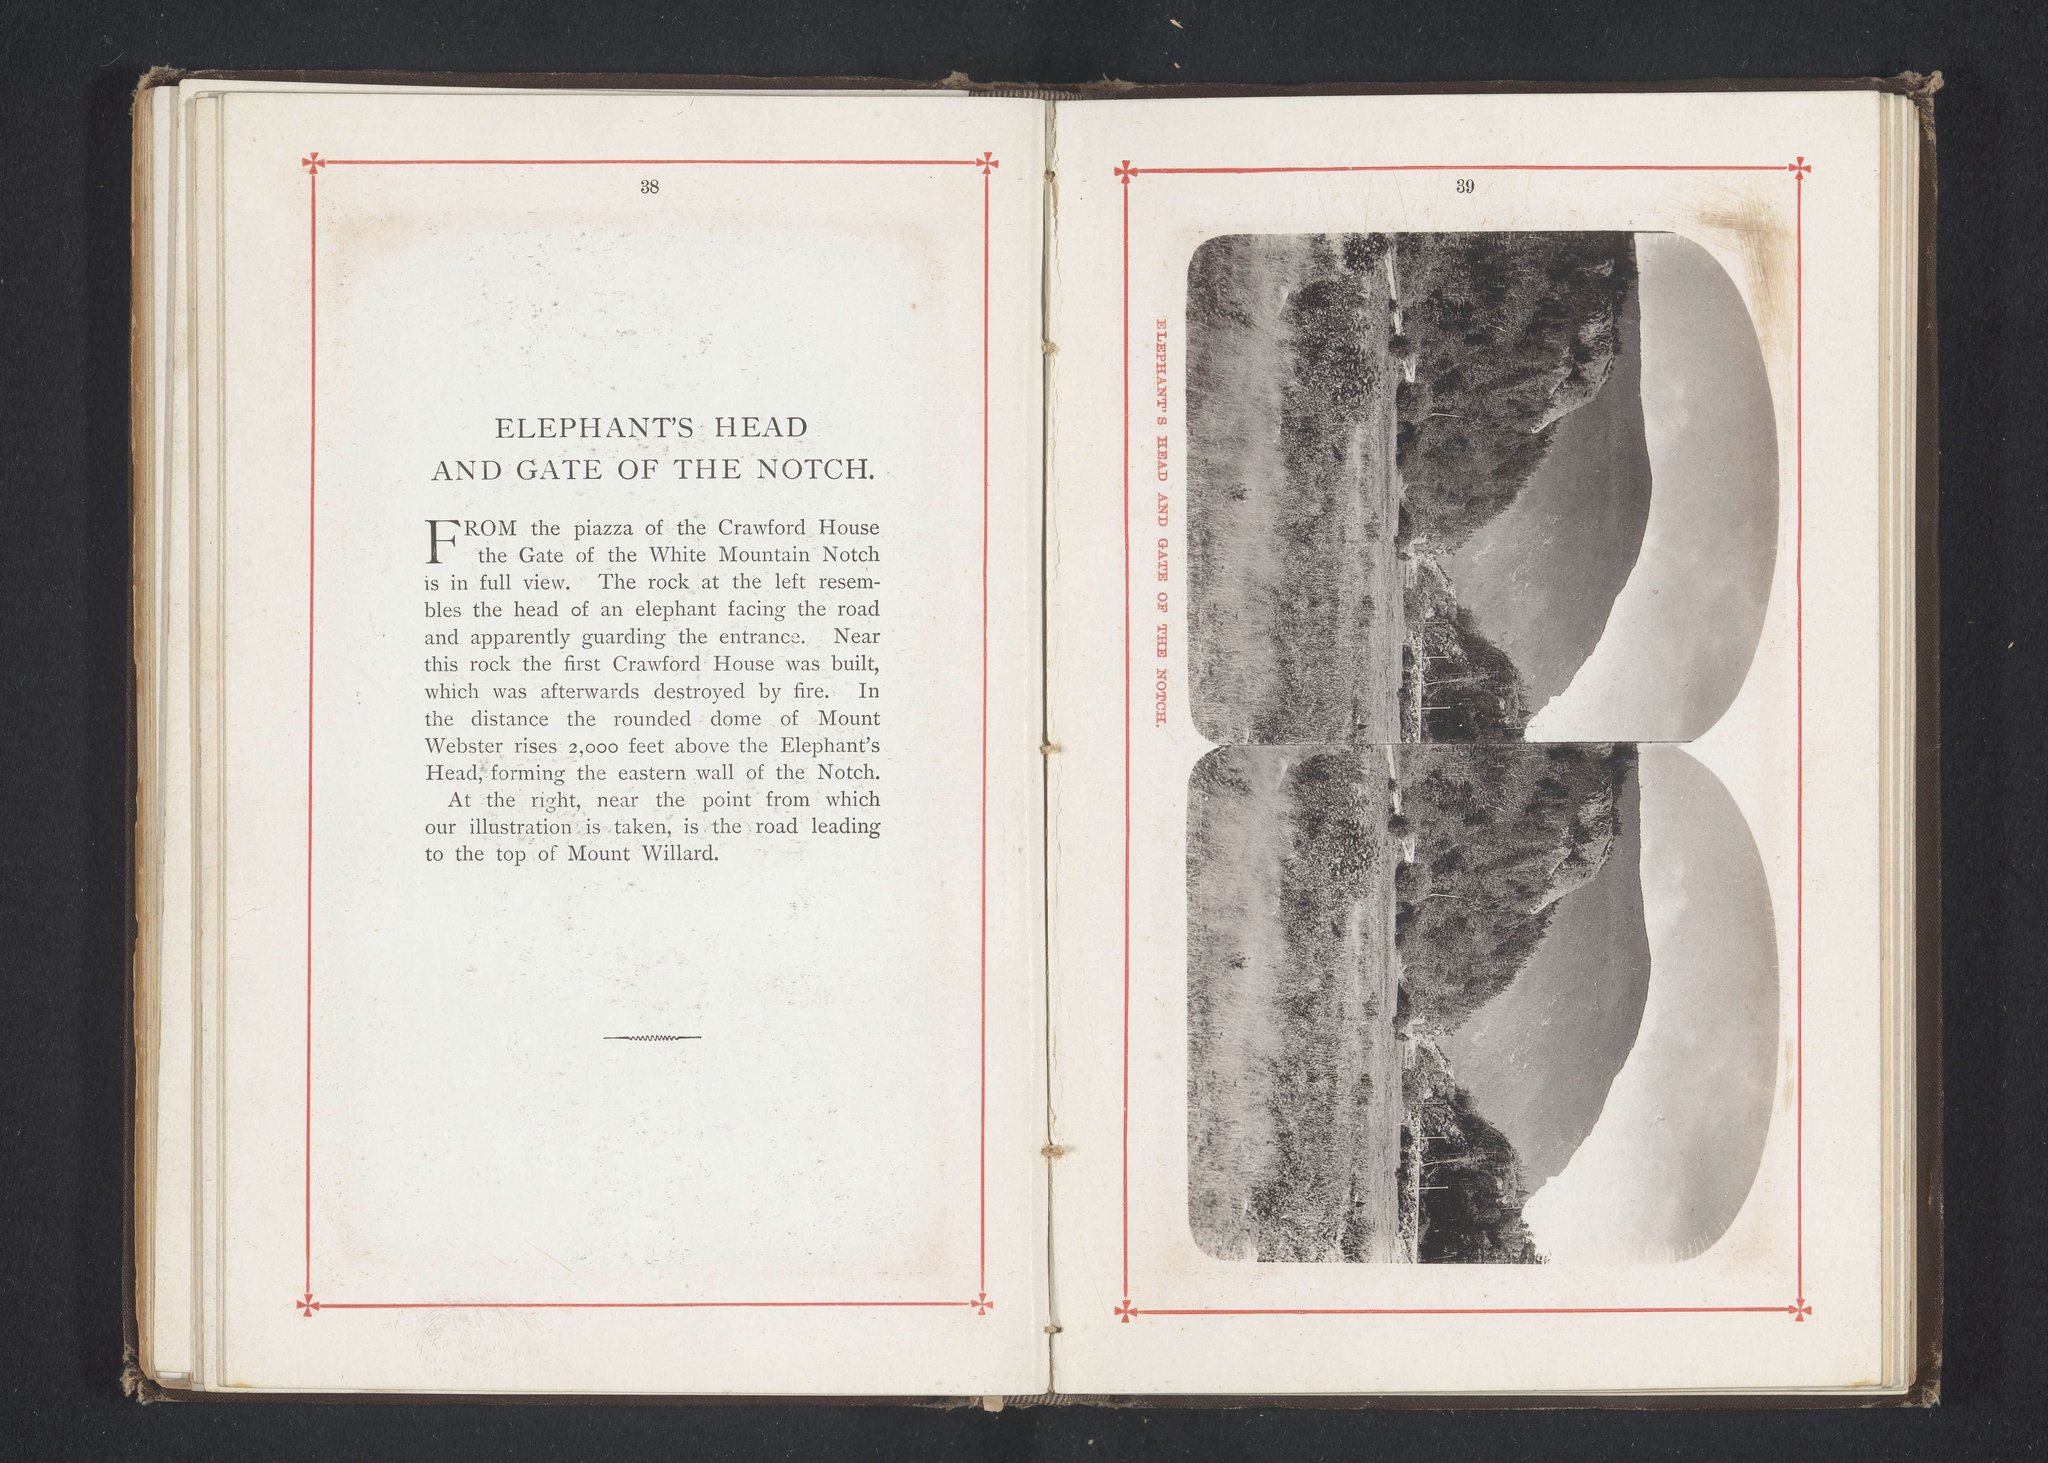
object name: stereograph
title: Elephant's head and gate of the Notch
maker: Anonymous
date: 1873-1878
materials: paper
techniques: photograph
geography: franconia notch state park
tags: meadow, pasture, mountains